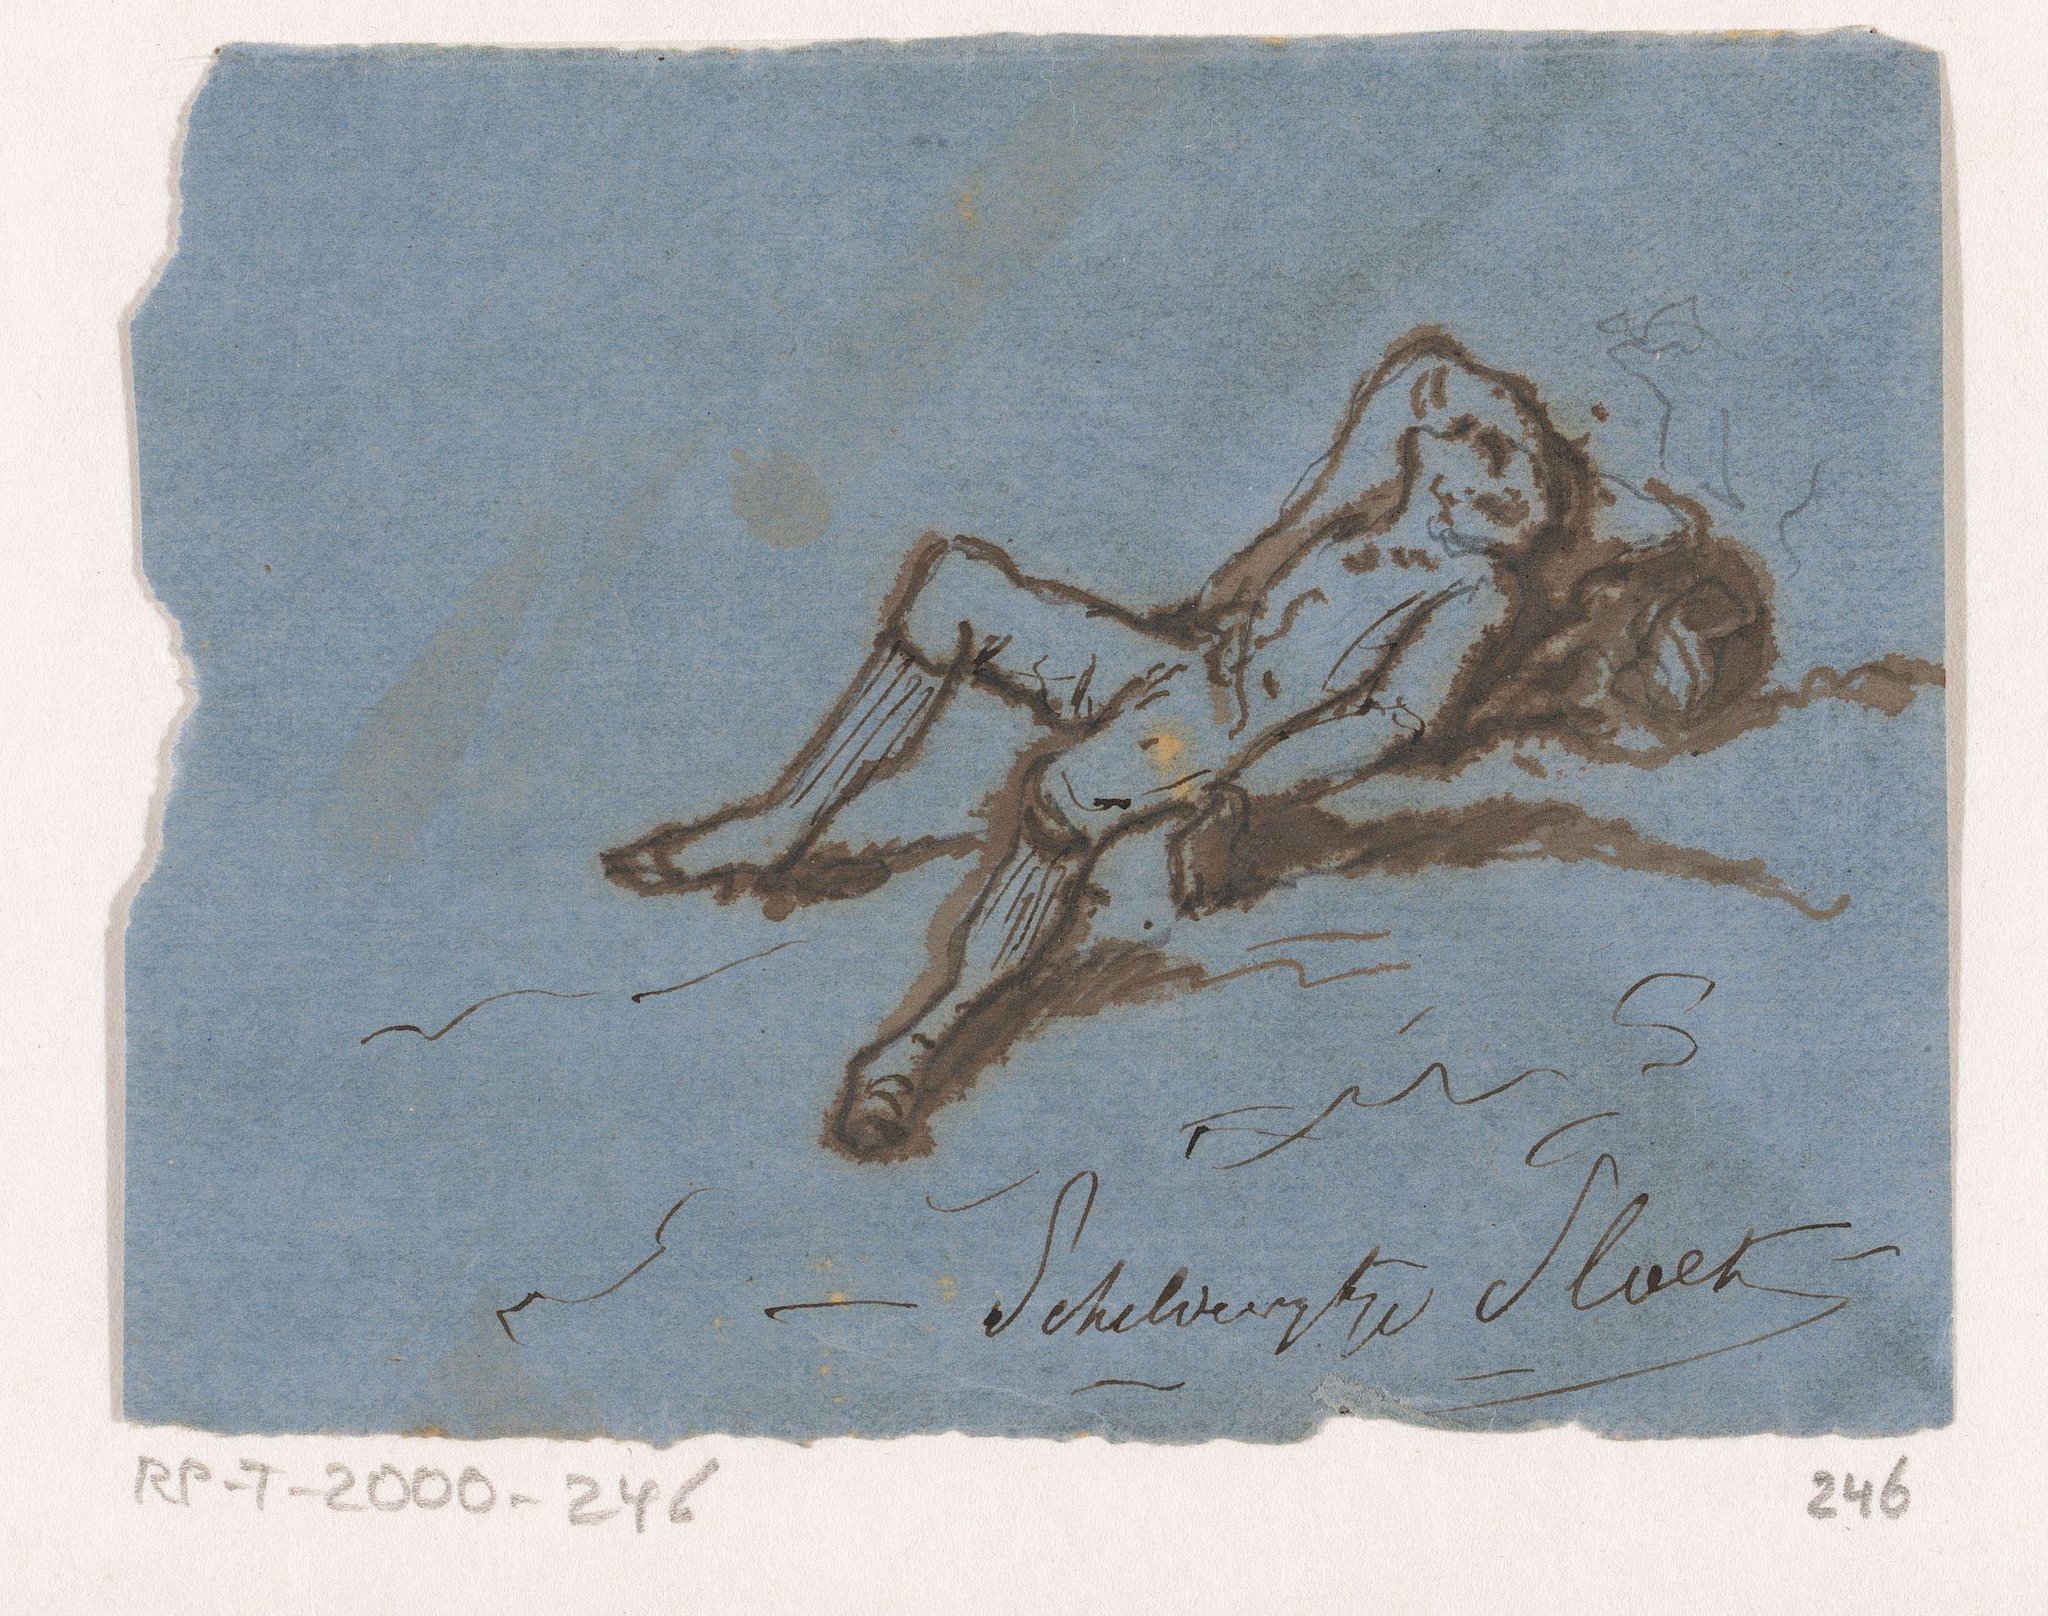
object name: drawing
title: Liggende man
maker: johannes tavenraat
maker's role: draughtsman, painter, print maker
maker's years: 1809-1881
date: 1840-1880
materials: ink, paper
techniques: pen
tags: lying on the back with hands under the head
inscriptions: annotation: ‘Schilderijte Sloet’, collector's mark: Lugt 2228